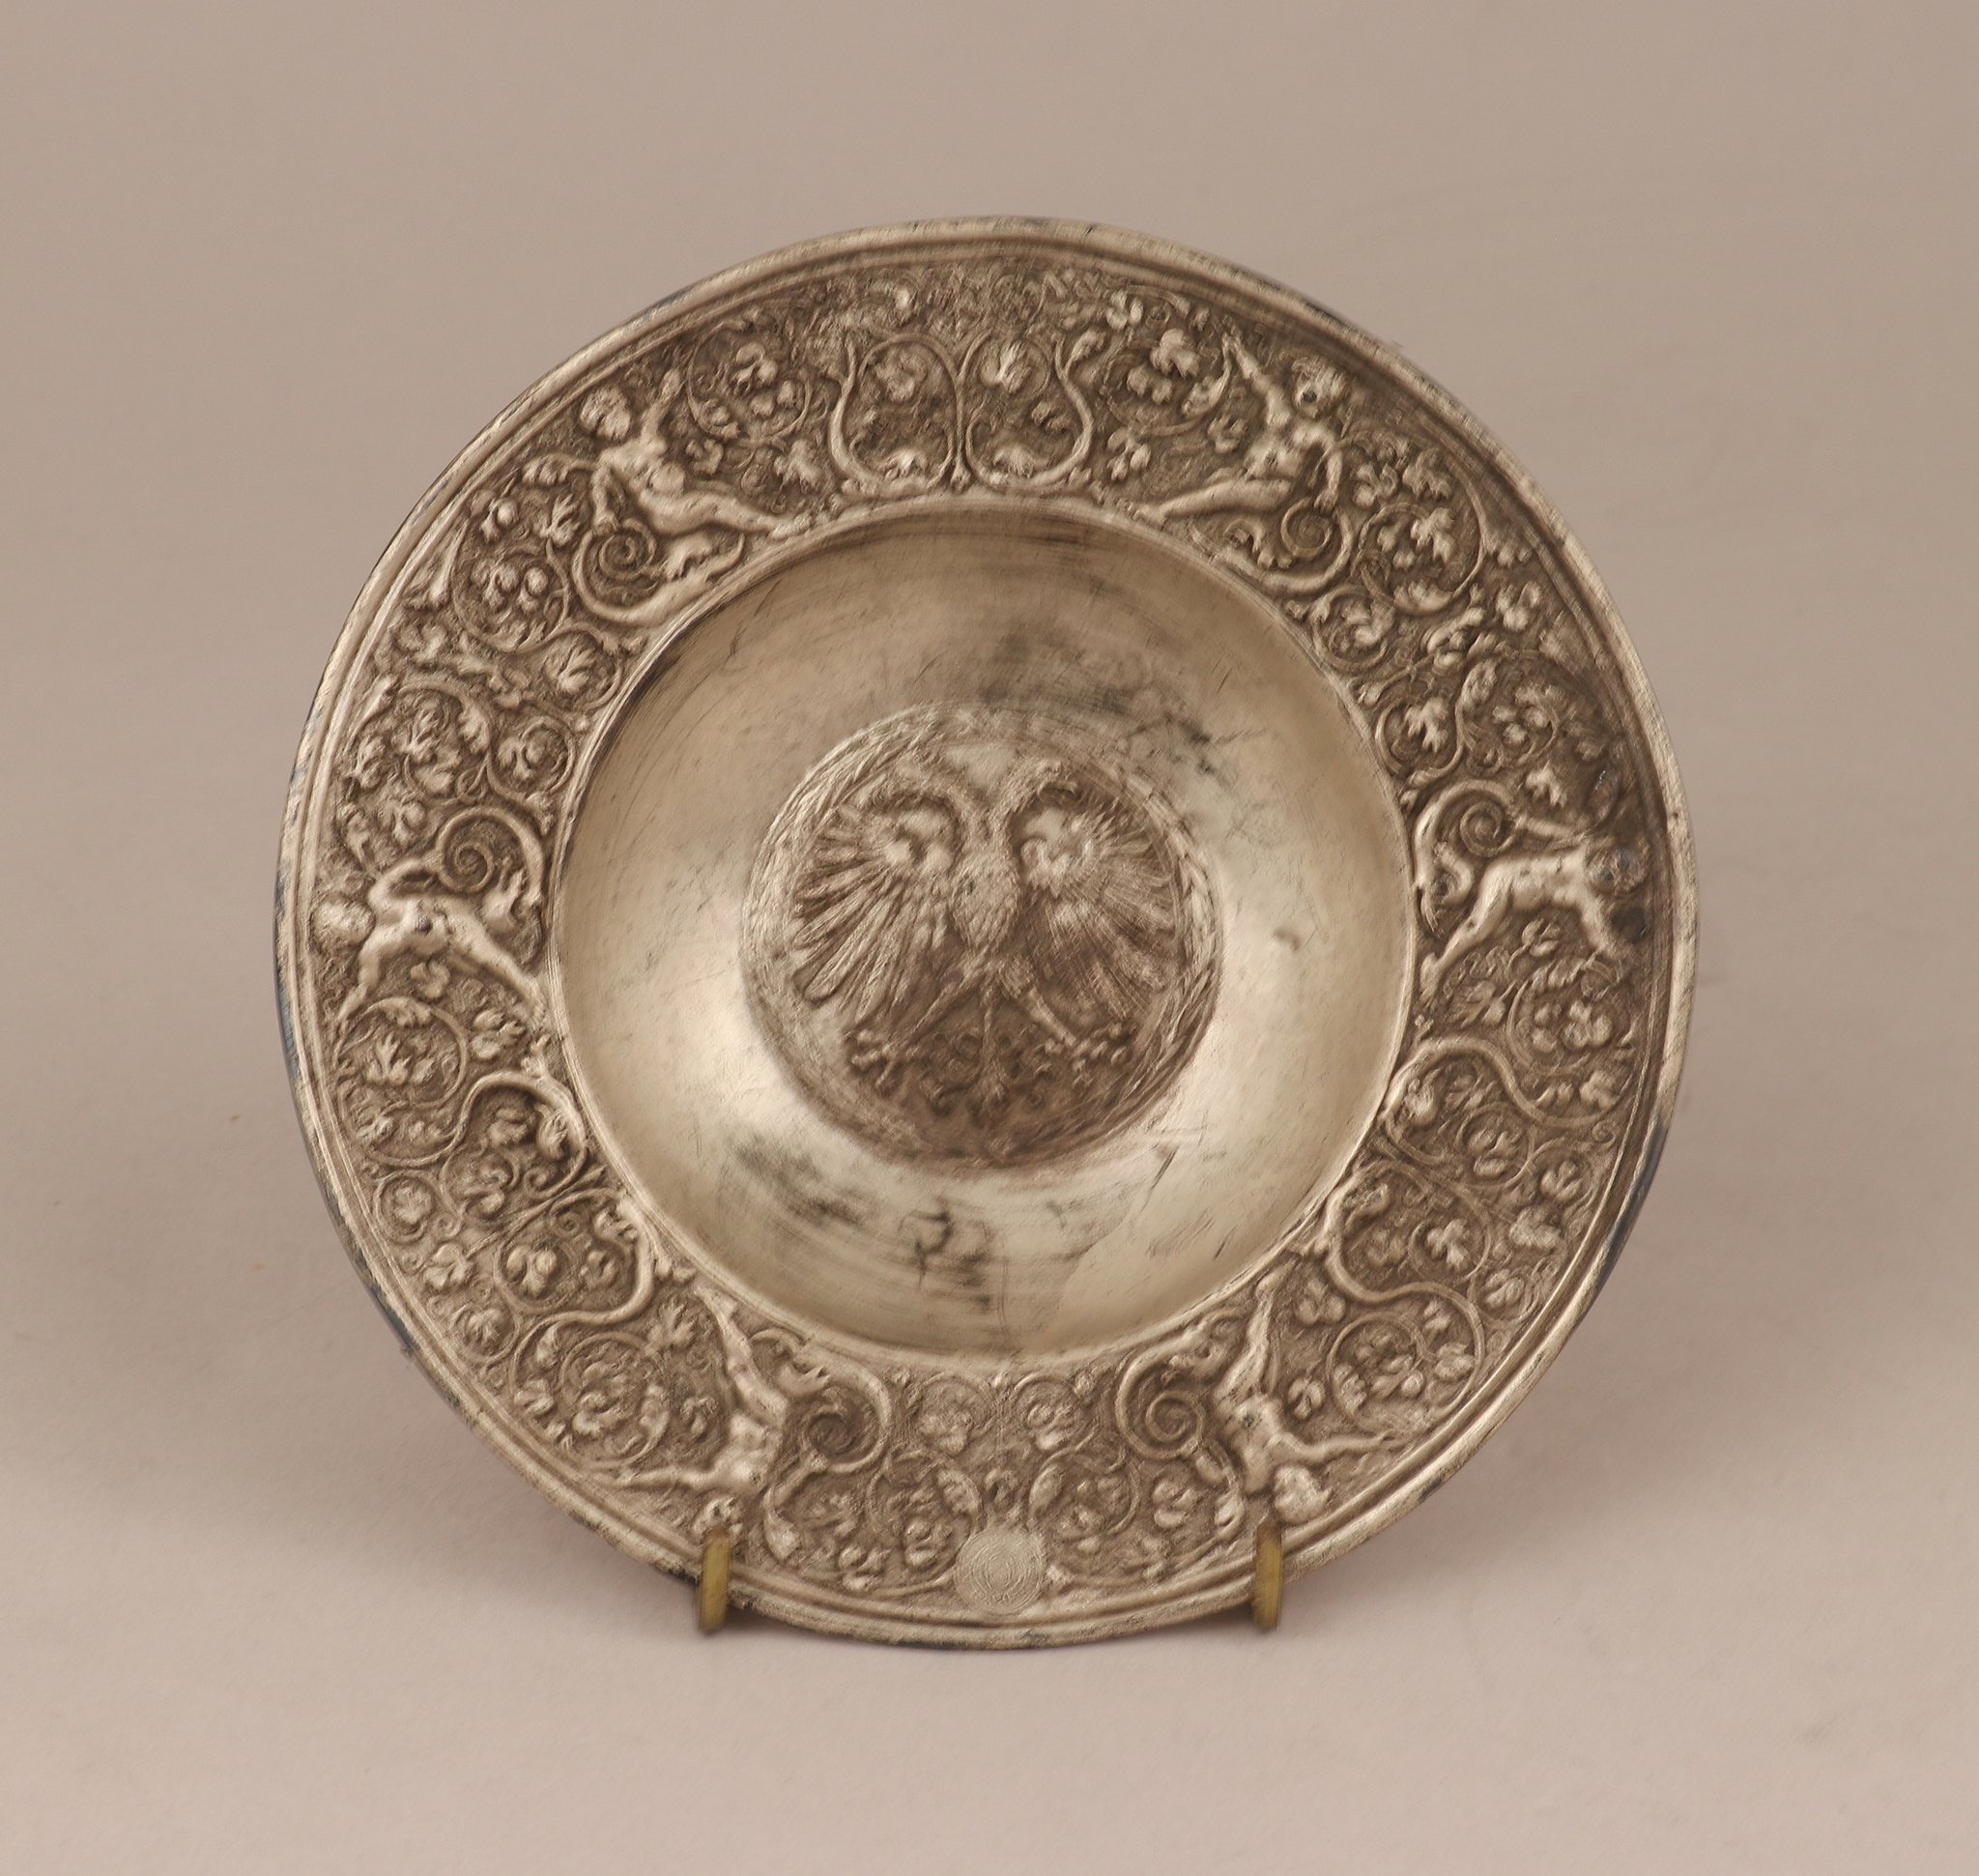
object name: plate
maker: elkington & co.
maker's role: manufacturer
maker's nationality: british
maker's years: 1829-1963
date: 1801-1900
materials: metal